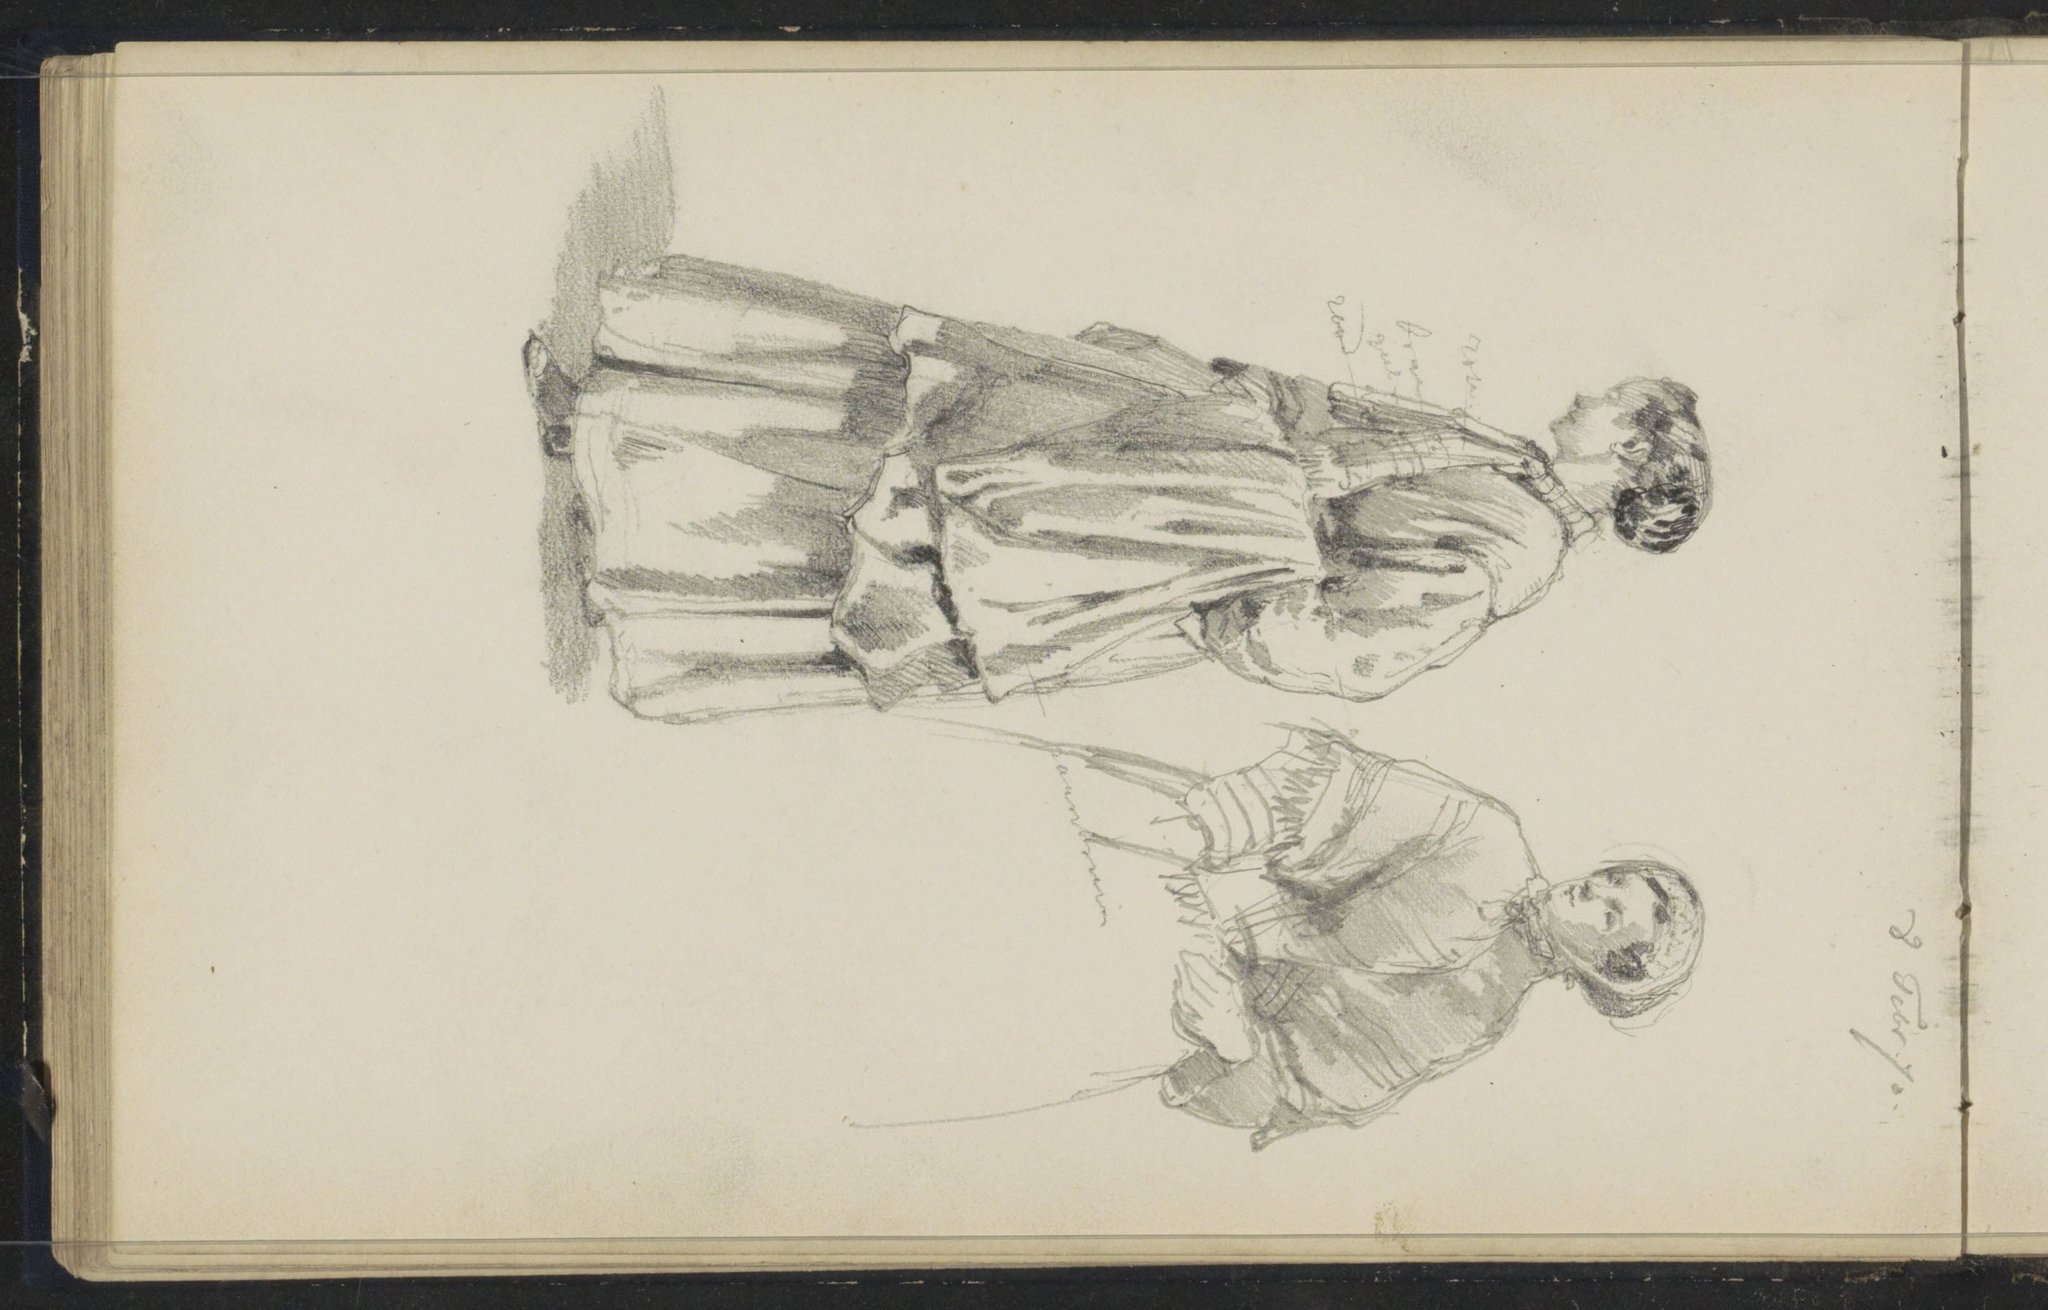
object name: sketchbook leaf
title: Twee vrouwen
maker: cornelis springer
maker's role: draughtsman, painter, print maker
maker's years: 1817-1891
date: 1870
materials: paper, pencil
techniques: stumping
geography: netherlands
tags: adult woman (+ two persons)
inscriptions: date: ‘8 Febr 70’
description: De linker vrouw draagt een draperie over haar arm. De rechter vrouw draagt een omslagdoek. Blad 22 verso uit een schetsboek met 40 bladen, vervaardigd in Woerden en Gouda.